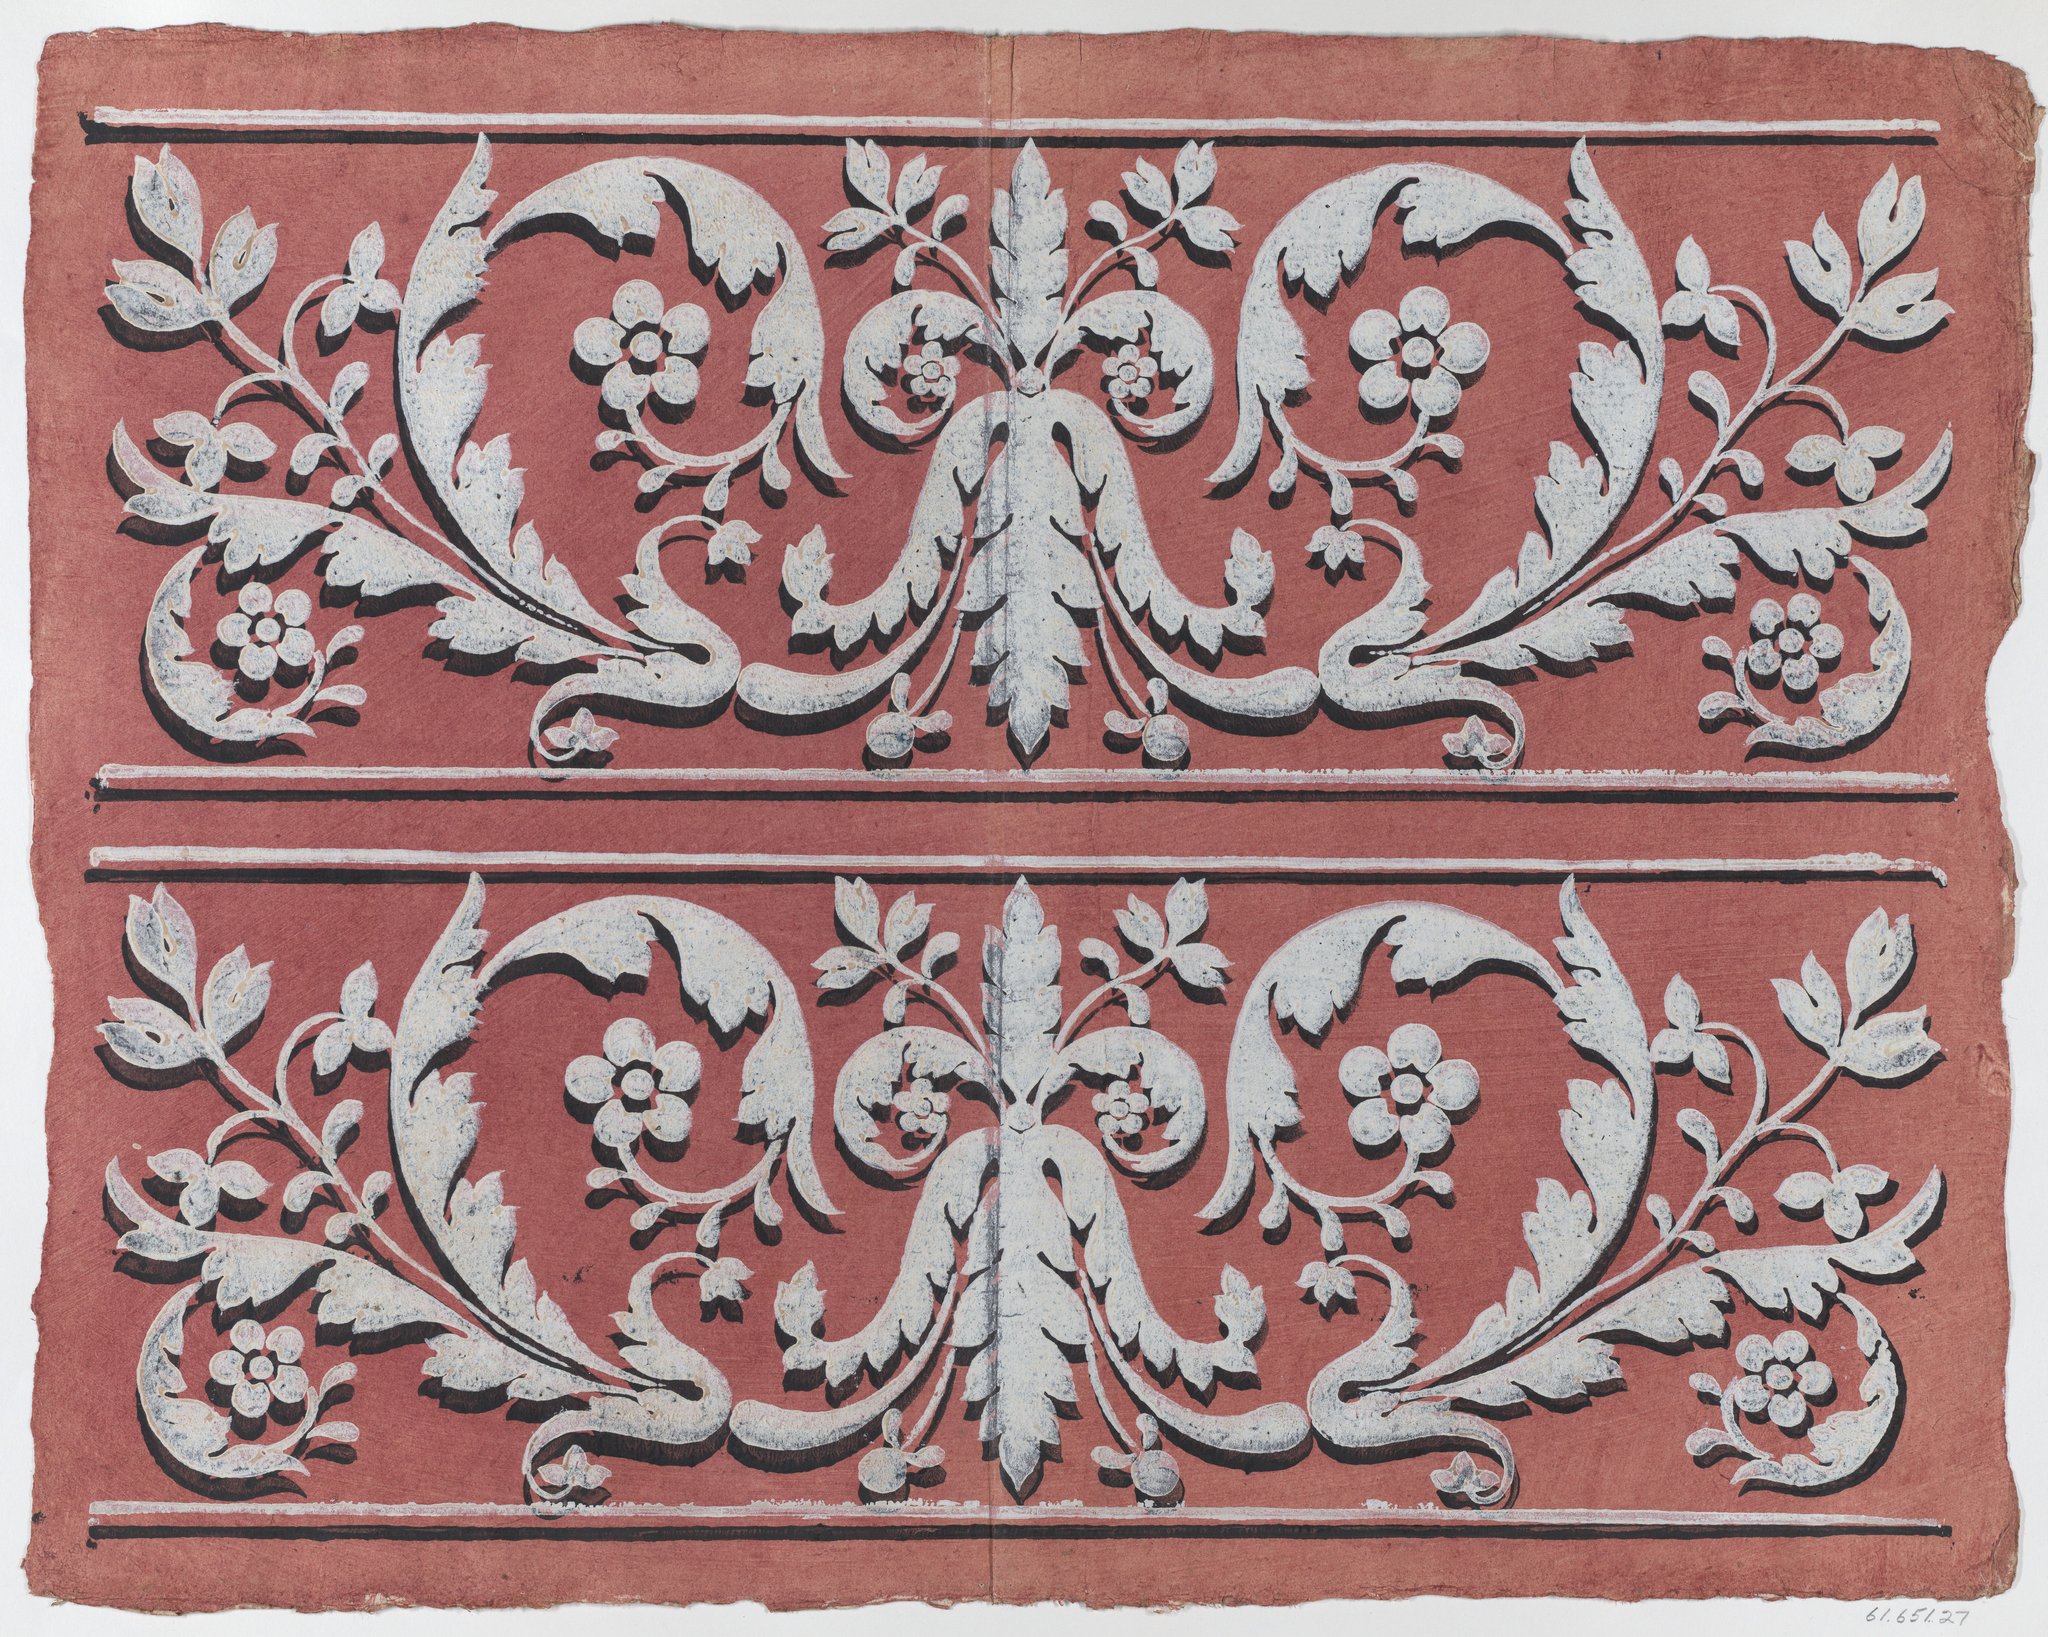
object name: print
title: Sheet with two borders with rinceau motif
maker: Anonymous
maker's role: artist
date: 1767-1866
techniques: relief print